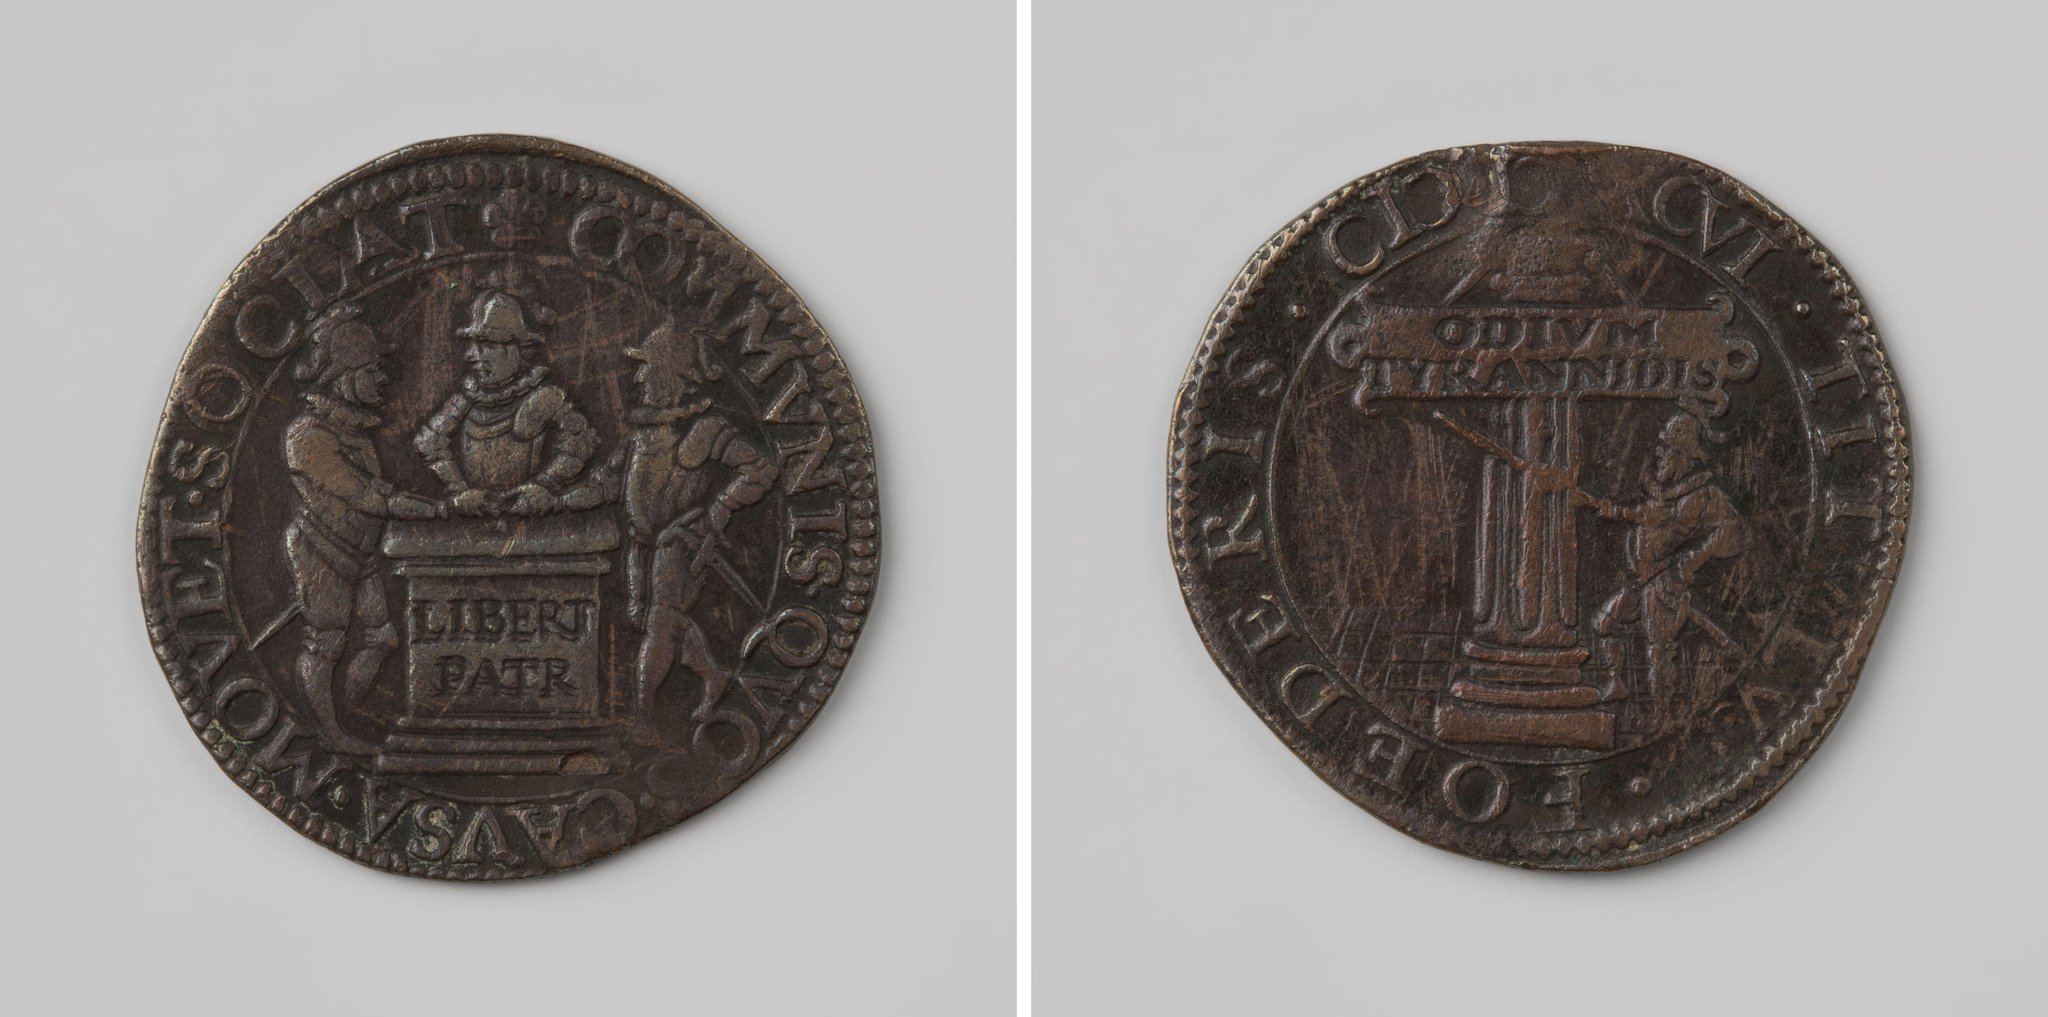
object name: jeton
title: Sluiting van het drievoudige verbond tussen Engeland, Frankrijk en de Republiek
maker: Anonymous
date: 1596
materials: silver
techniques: striking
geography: dordrecht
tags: netherlands, france, england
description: Zilveren penning. Voorzijde: drie soldaten, voorstellende de drie verdragspartners, staande rond altaar met opschrift binnen omschrift. Keerzijde: soldaat, wijzend met stok op bord met opschrift, hangend aan zuil binnen omschrift.